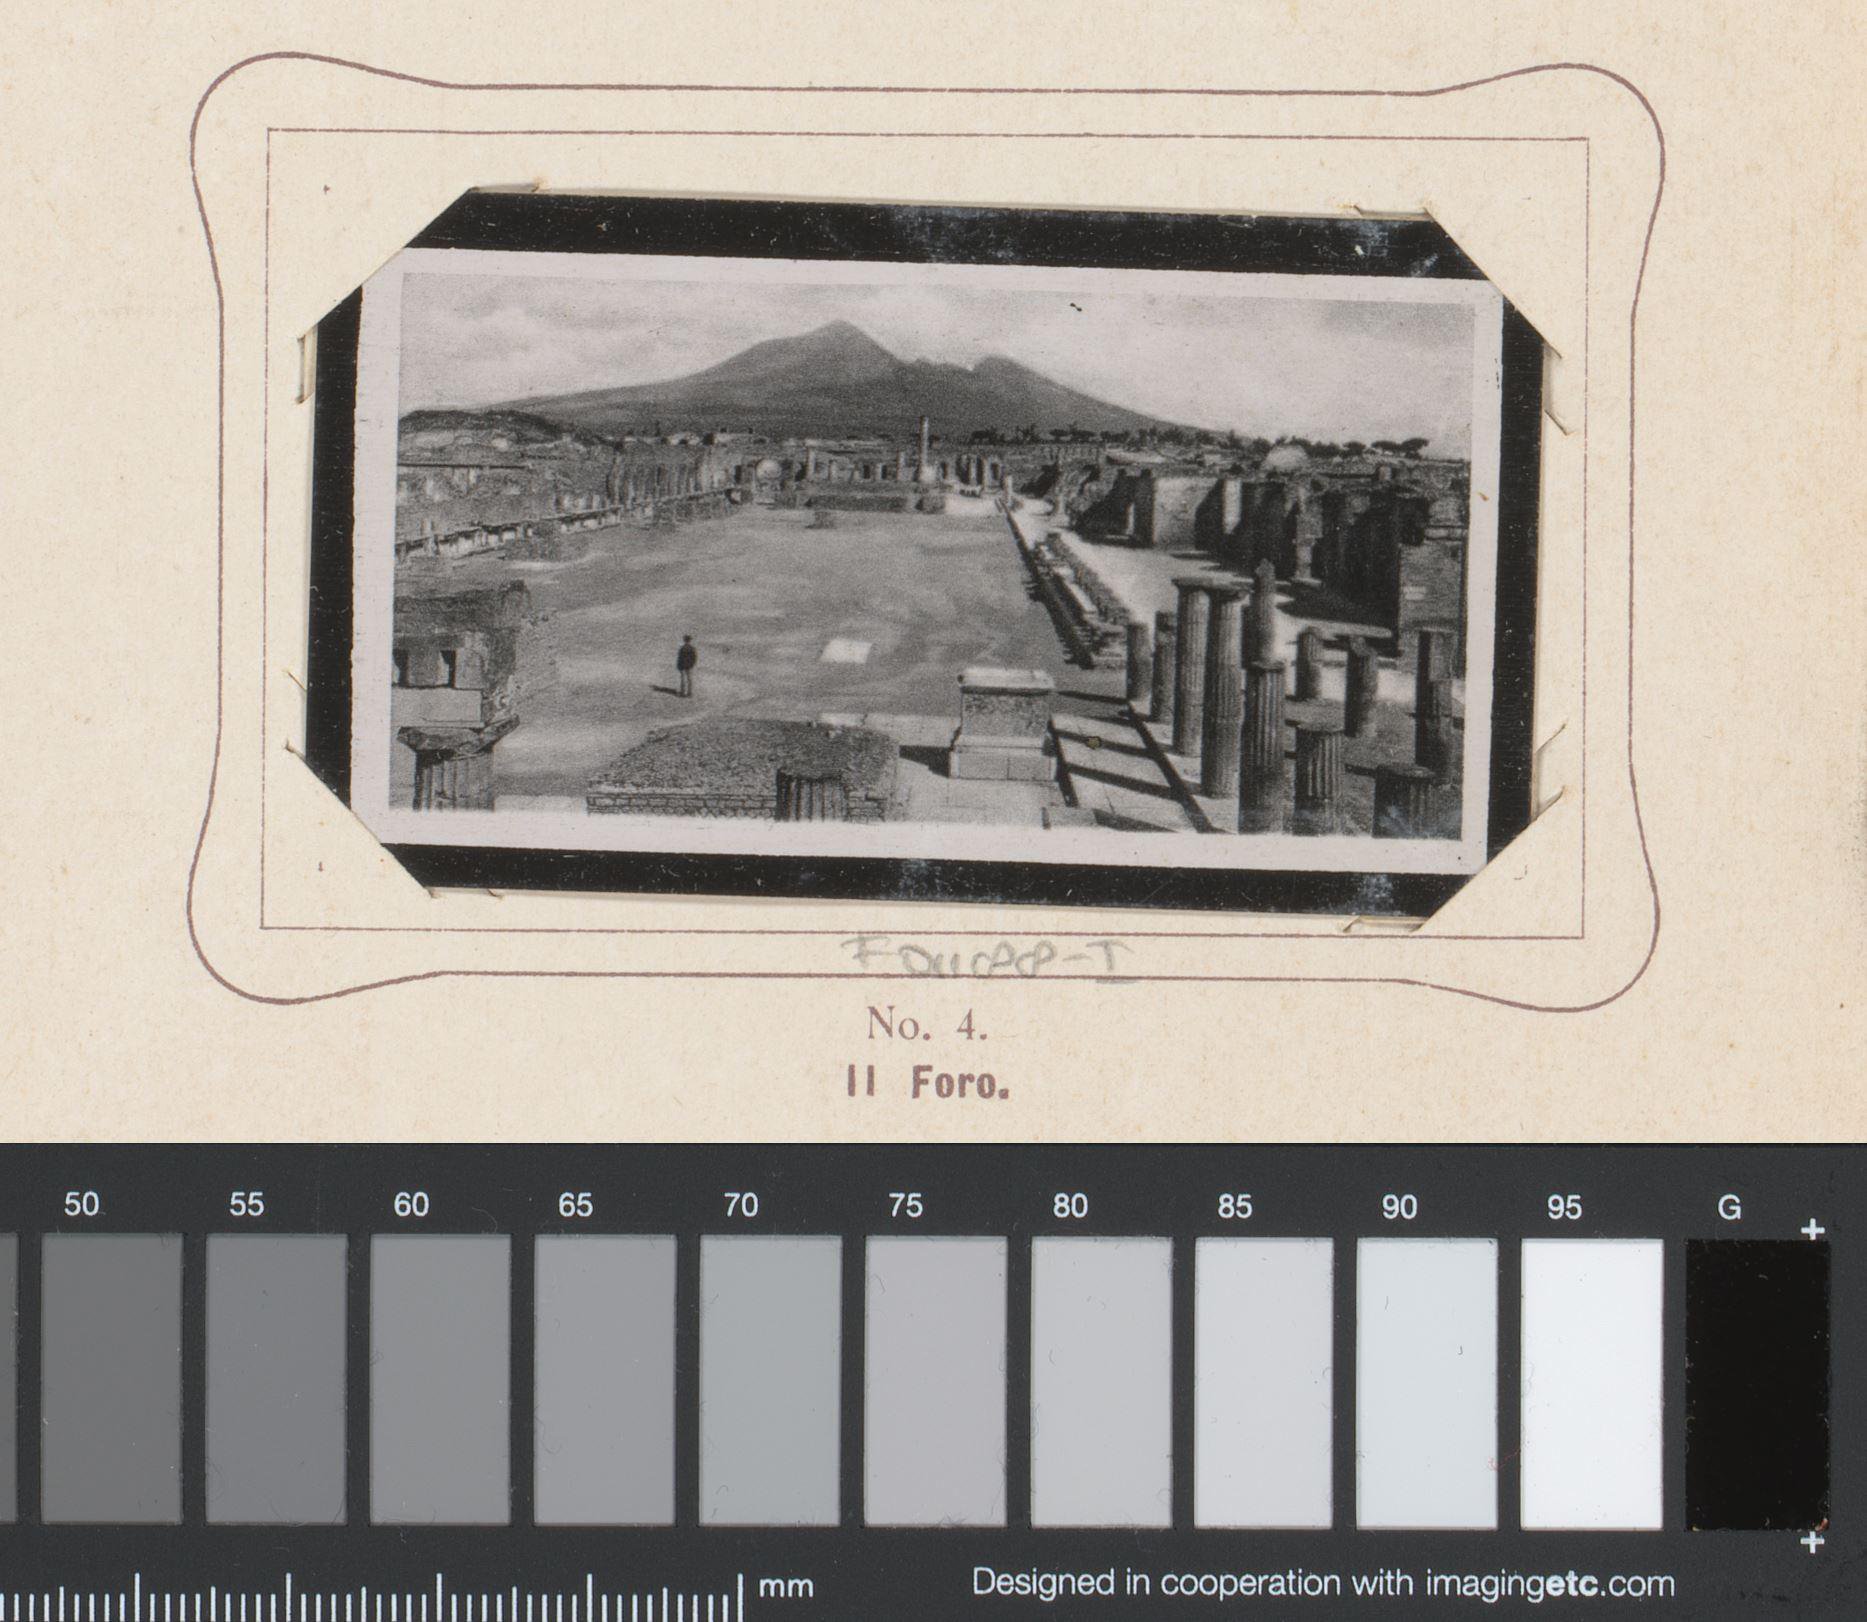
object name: photomechanical print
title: Ruïnes van het Foro Civile in Pompeï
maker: Anonymous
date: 1906-1907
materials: paper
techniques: photograph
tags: landscape with ruins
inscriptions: inscription: ‘No. 4./ Il Foro.’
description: Deze prent maakt deel uit van een album.